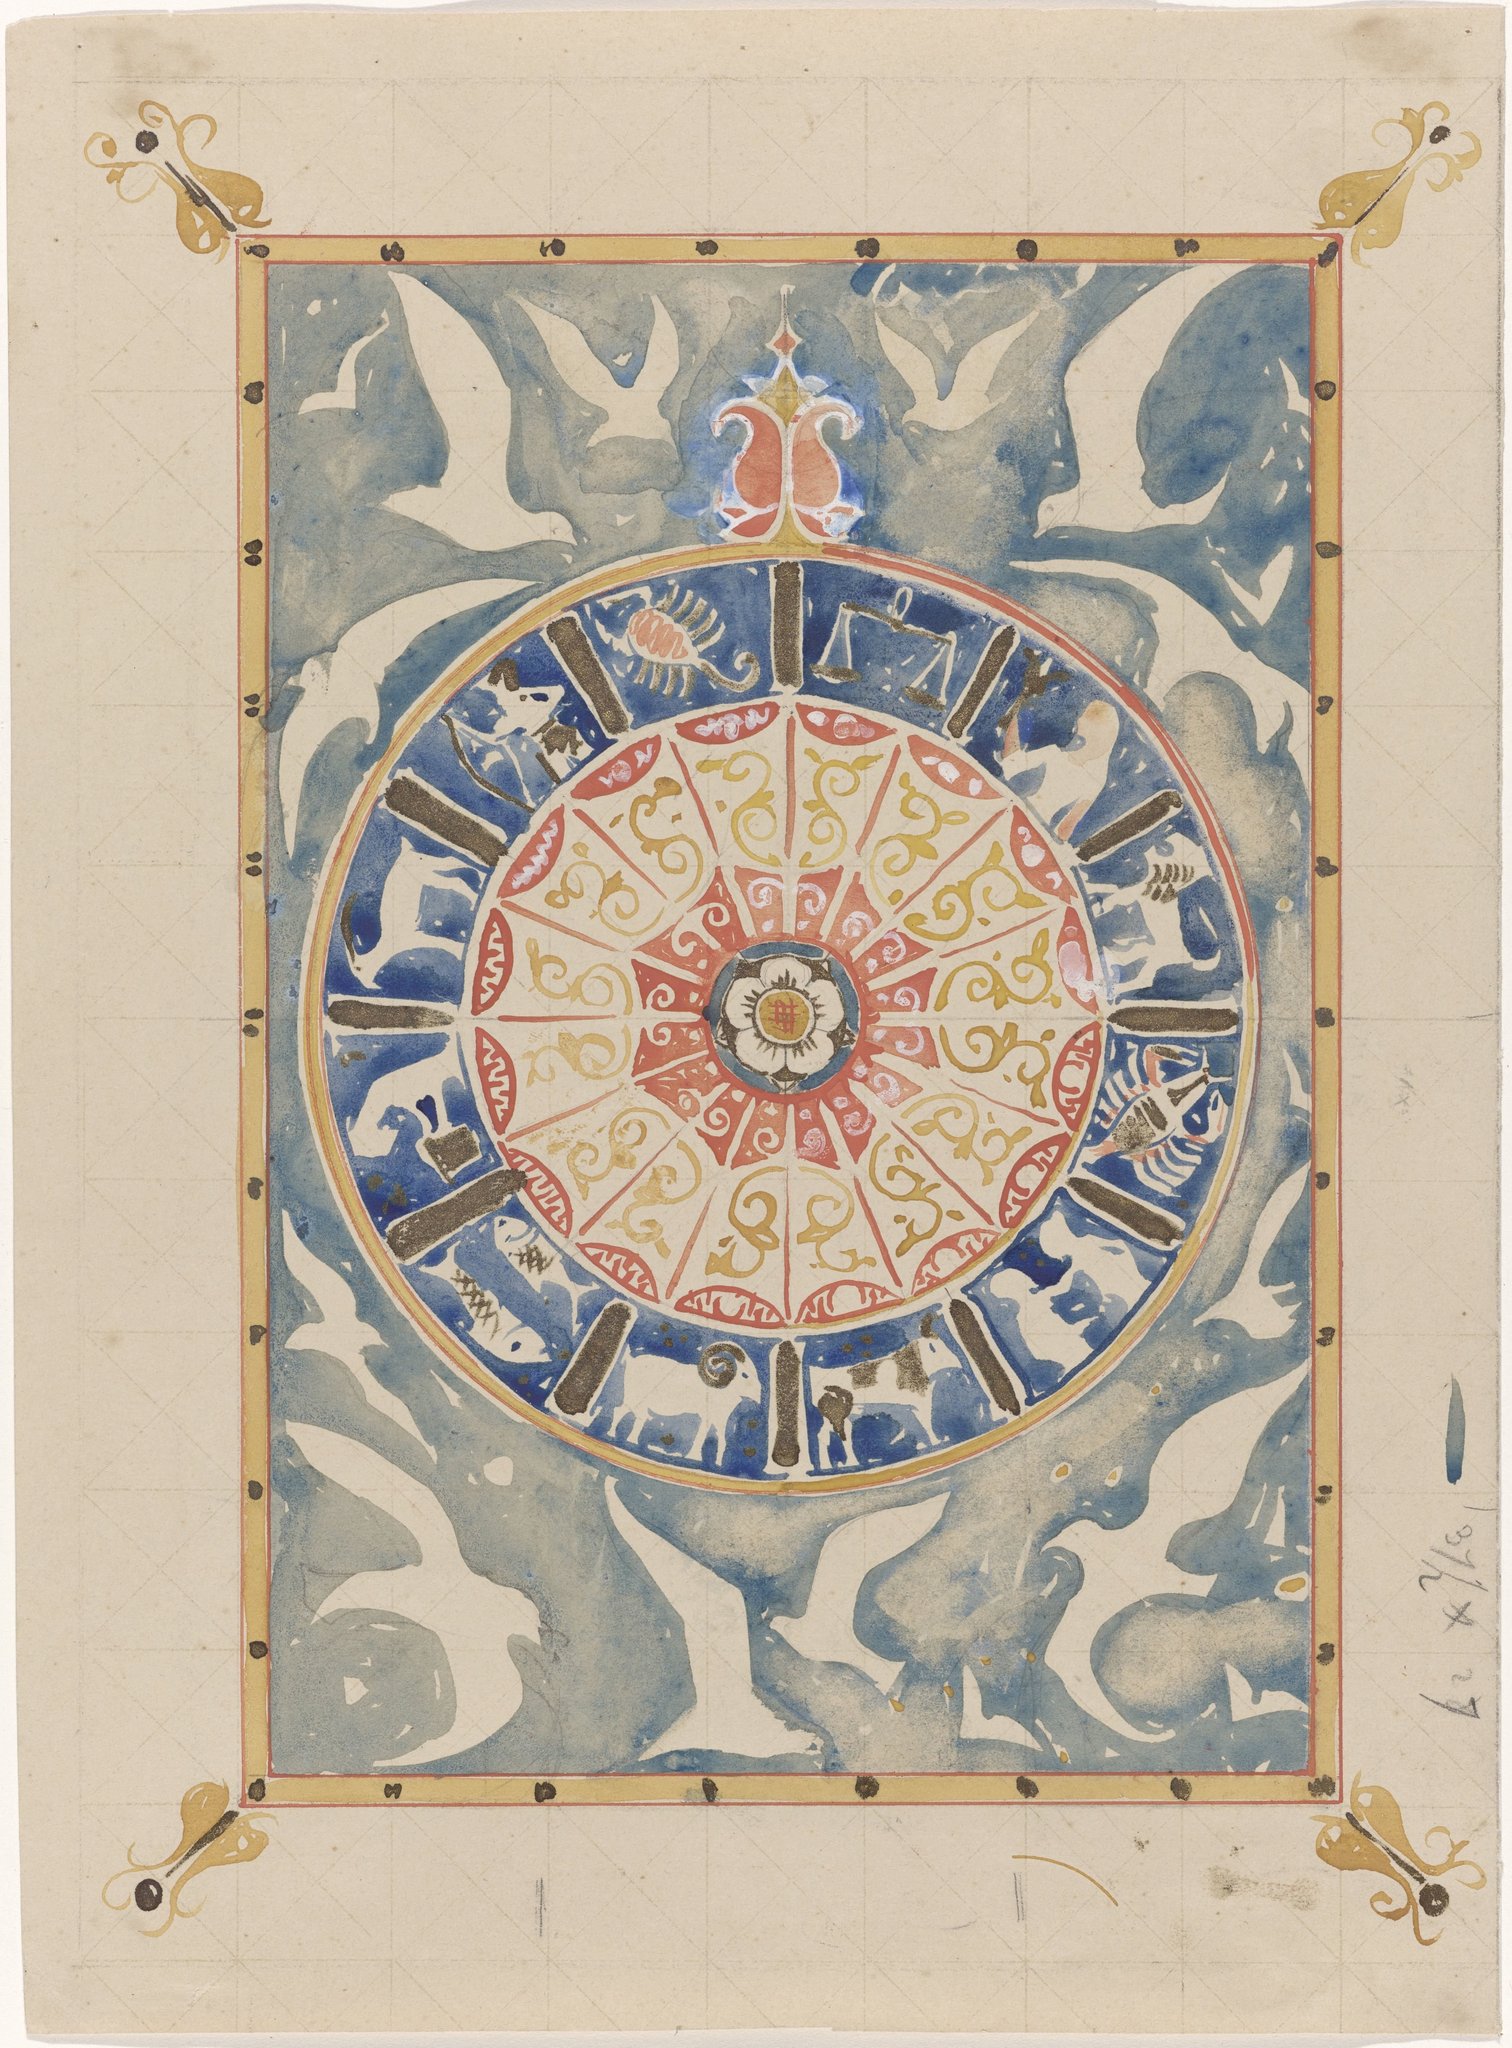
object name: design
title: Cirkel met tekens van de dierenriem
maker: carel adolph lion cachet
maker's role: draughtsman, print maker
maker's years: 1864-1945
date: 1874-1945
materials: paint, paper, pencil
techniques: brush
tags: zodiac; the twelve zodiacal signs together